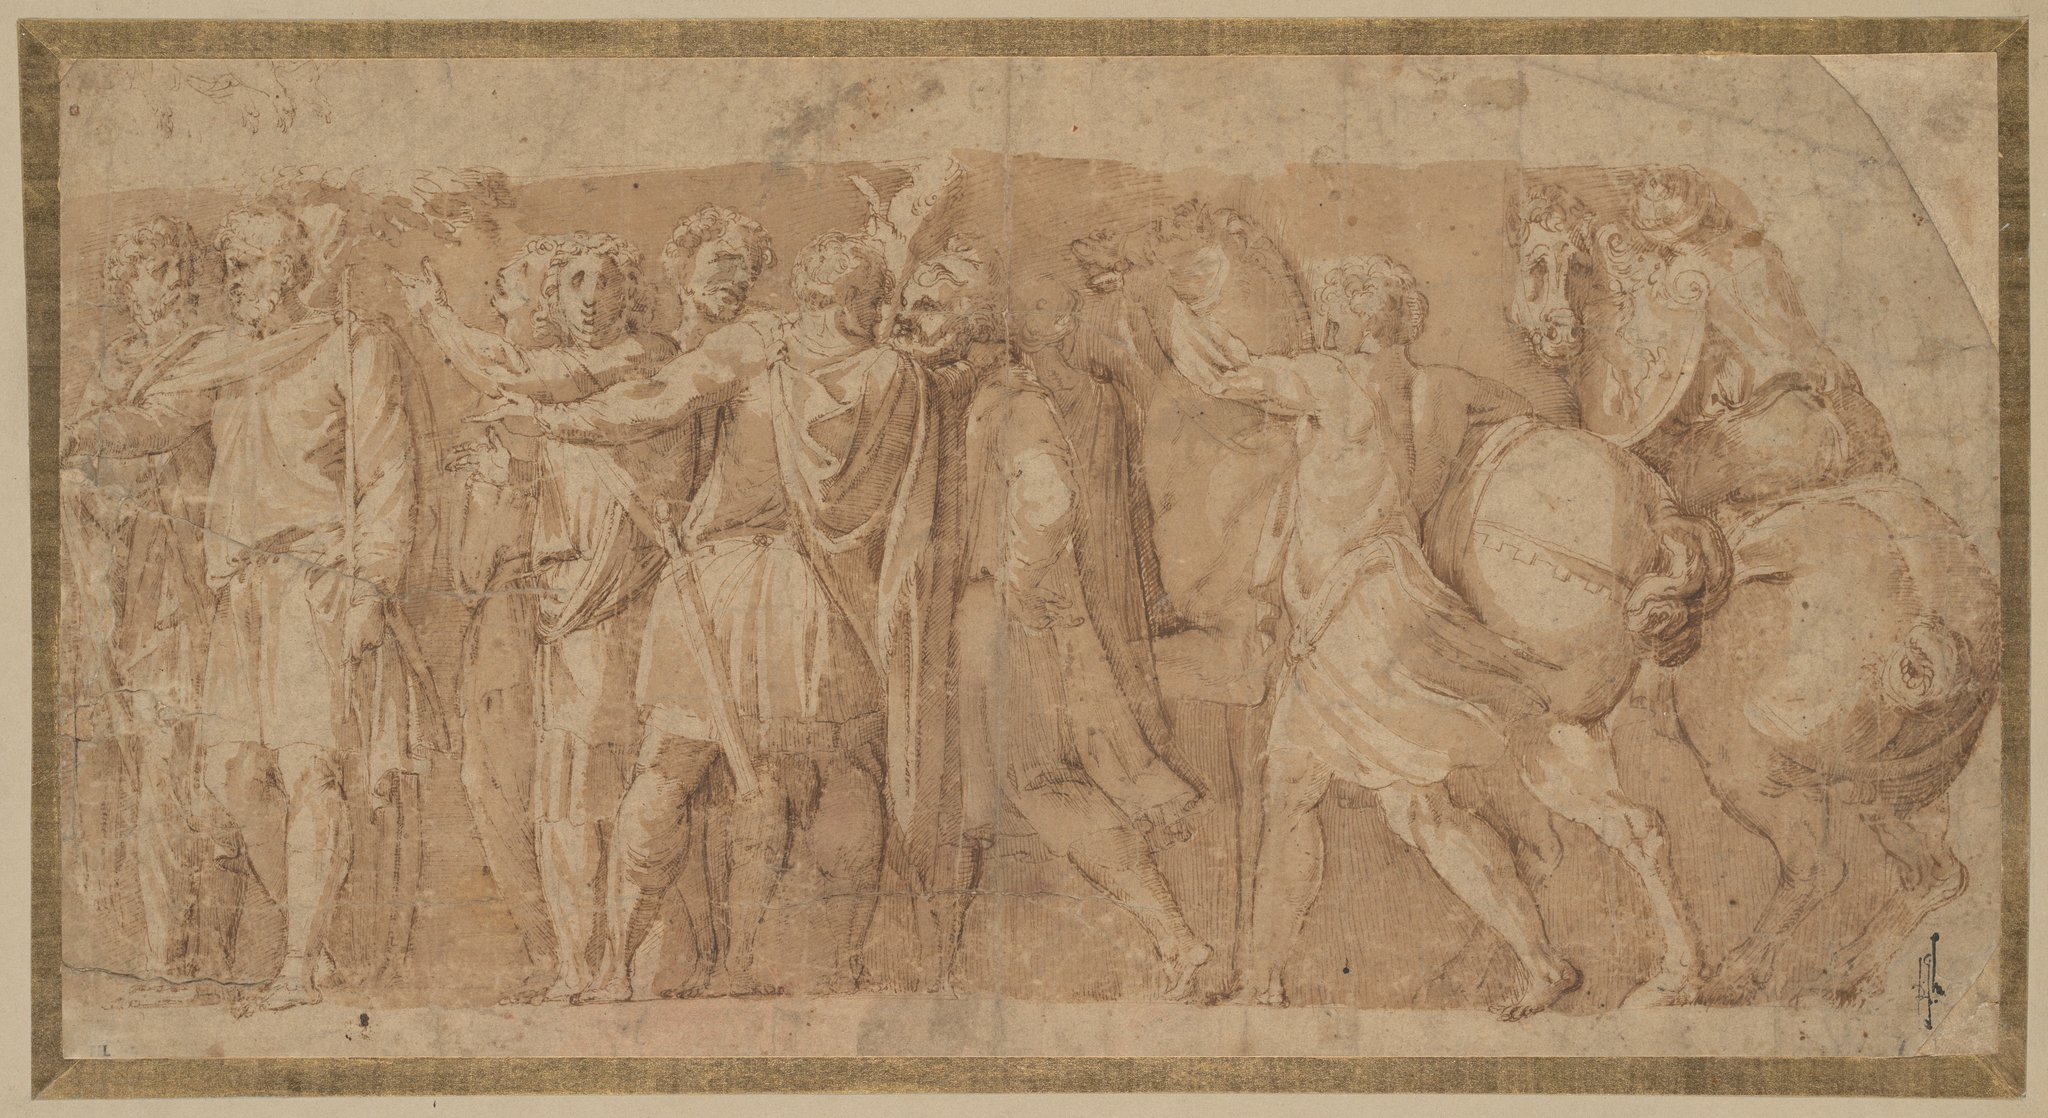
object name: drawing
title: Frieze with Male Figures and Two Horses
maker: polidoro da caravaggio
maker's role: artist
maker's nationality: italian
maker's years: 1494-1548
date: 1534-1566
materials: ink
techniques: pen, wash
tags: men,horses